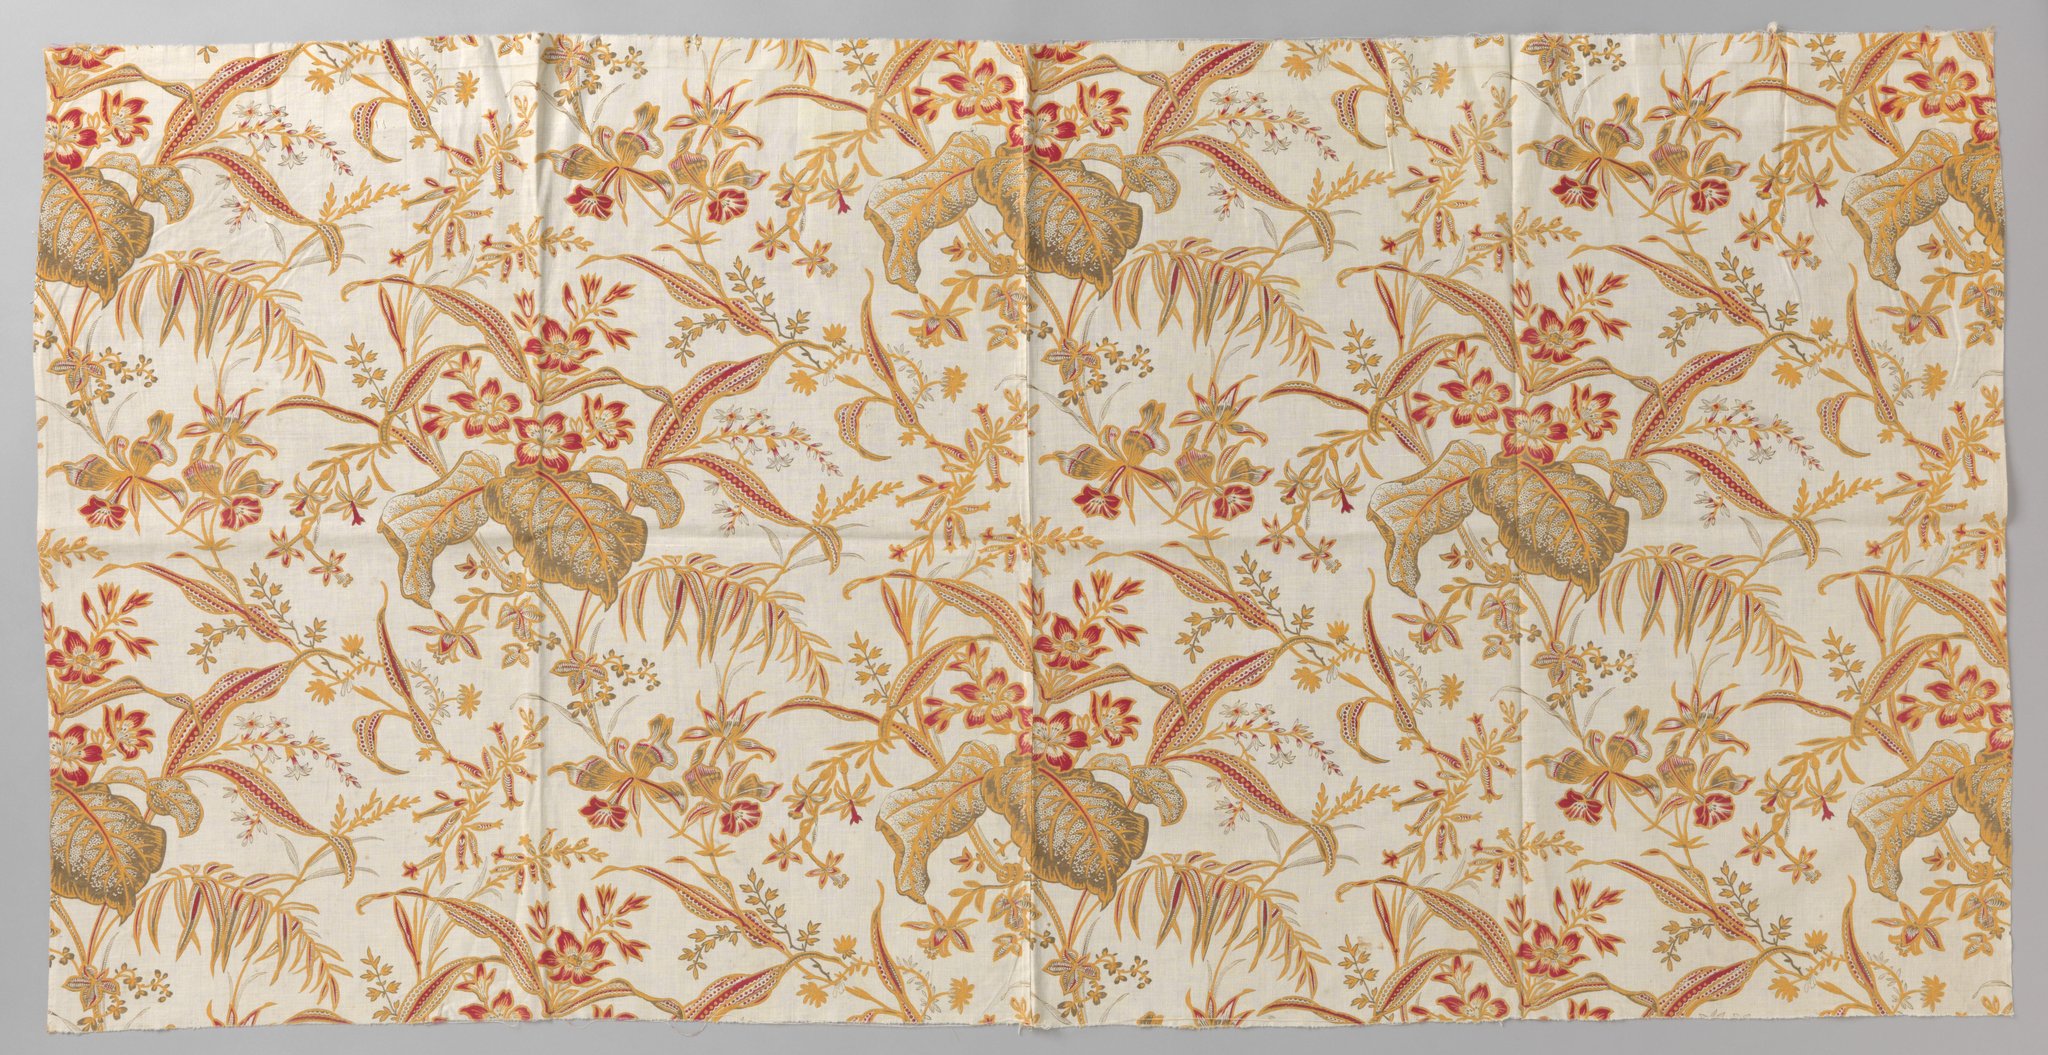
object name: curtain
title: Metrage gordijnstof van namaak-sits van linnen, gedrukt met gele en rode exotische bladeren en bloemen.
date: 1890-1910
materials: linen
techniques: printing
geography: alsace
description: Metrage gordijnstof (A en B) van namaak-sits van linnen, gedrukt met gele en rode exotische bladeren en bloemen. Patroon: Schuin naar links opgaande stengels met vertakkingen groeien oneindig door, waartussen orchideeën en brede grijs gestippelde balderen met rode nerf en rode trosbloemen. Ook wuivende palmtakken en lancetbladeren met rode en gele stippen en klokjes aan lange stelen, witte hyacinthen, trosnarcissen en graspluimen. Frankrijk of de Elzas, 19de of begin 20ste eeuw.